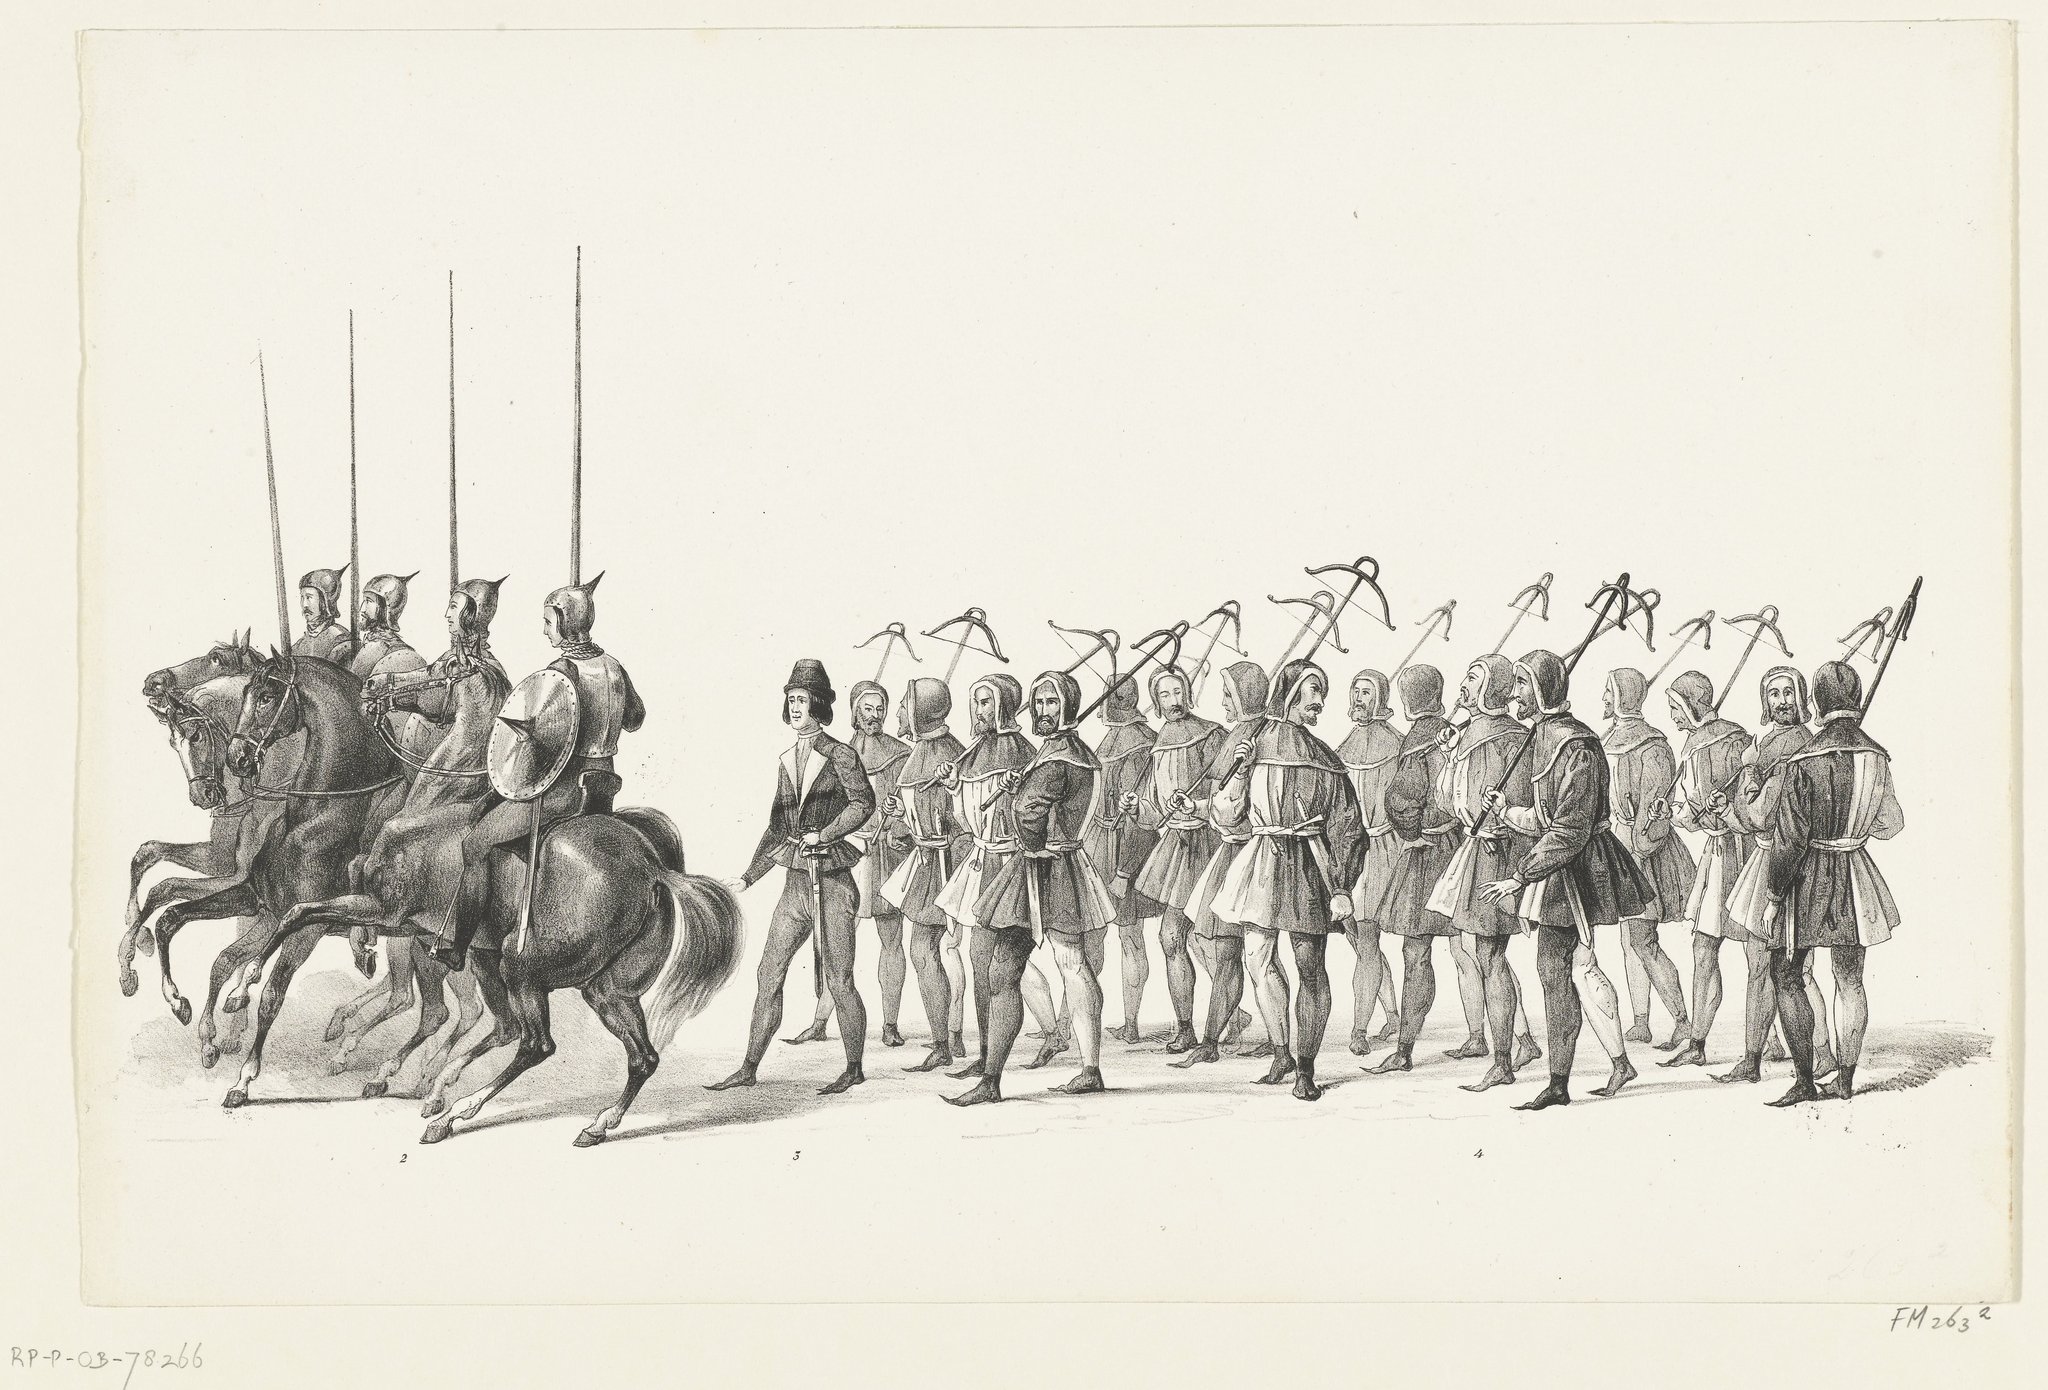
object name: print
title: Maskerade van de intocht van hertog Jan van Beieren te Leiden op 18 augustus 1420 door de Leidse studenten op 8 februari 1840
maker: Anonymous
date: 1840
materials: paper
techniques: lithograph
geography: netherlands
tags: jan van beieren, students' pageant, triumphal entry and public reception, pageant, 'entrée solennelle', 'joyeuse entrée', leiden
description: Optocht nrs 2-4: ruiters en boogschutters. Onderdeel van de prentserie van de Maskerade van de intocht van hertog Jan van Beieren te Leiden op 18 augustus 1420 door de Leidse studenten op 8 februari 1840.